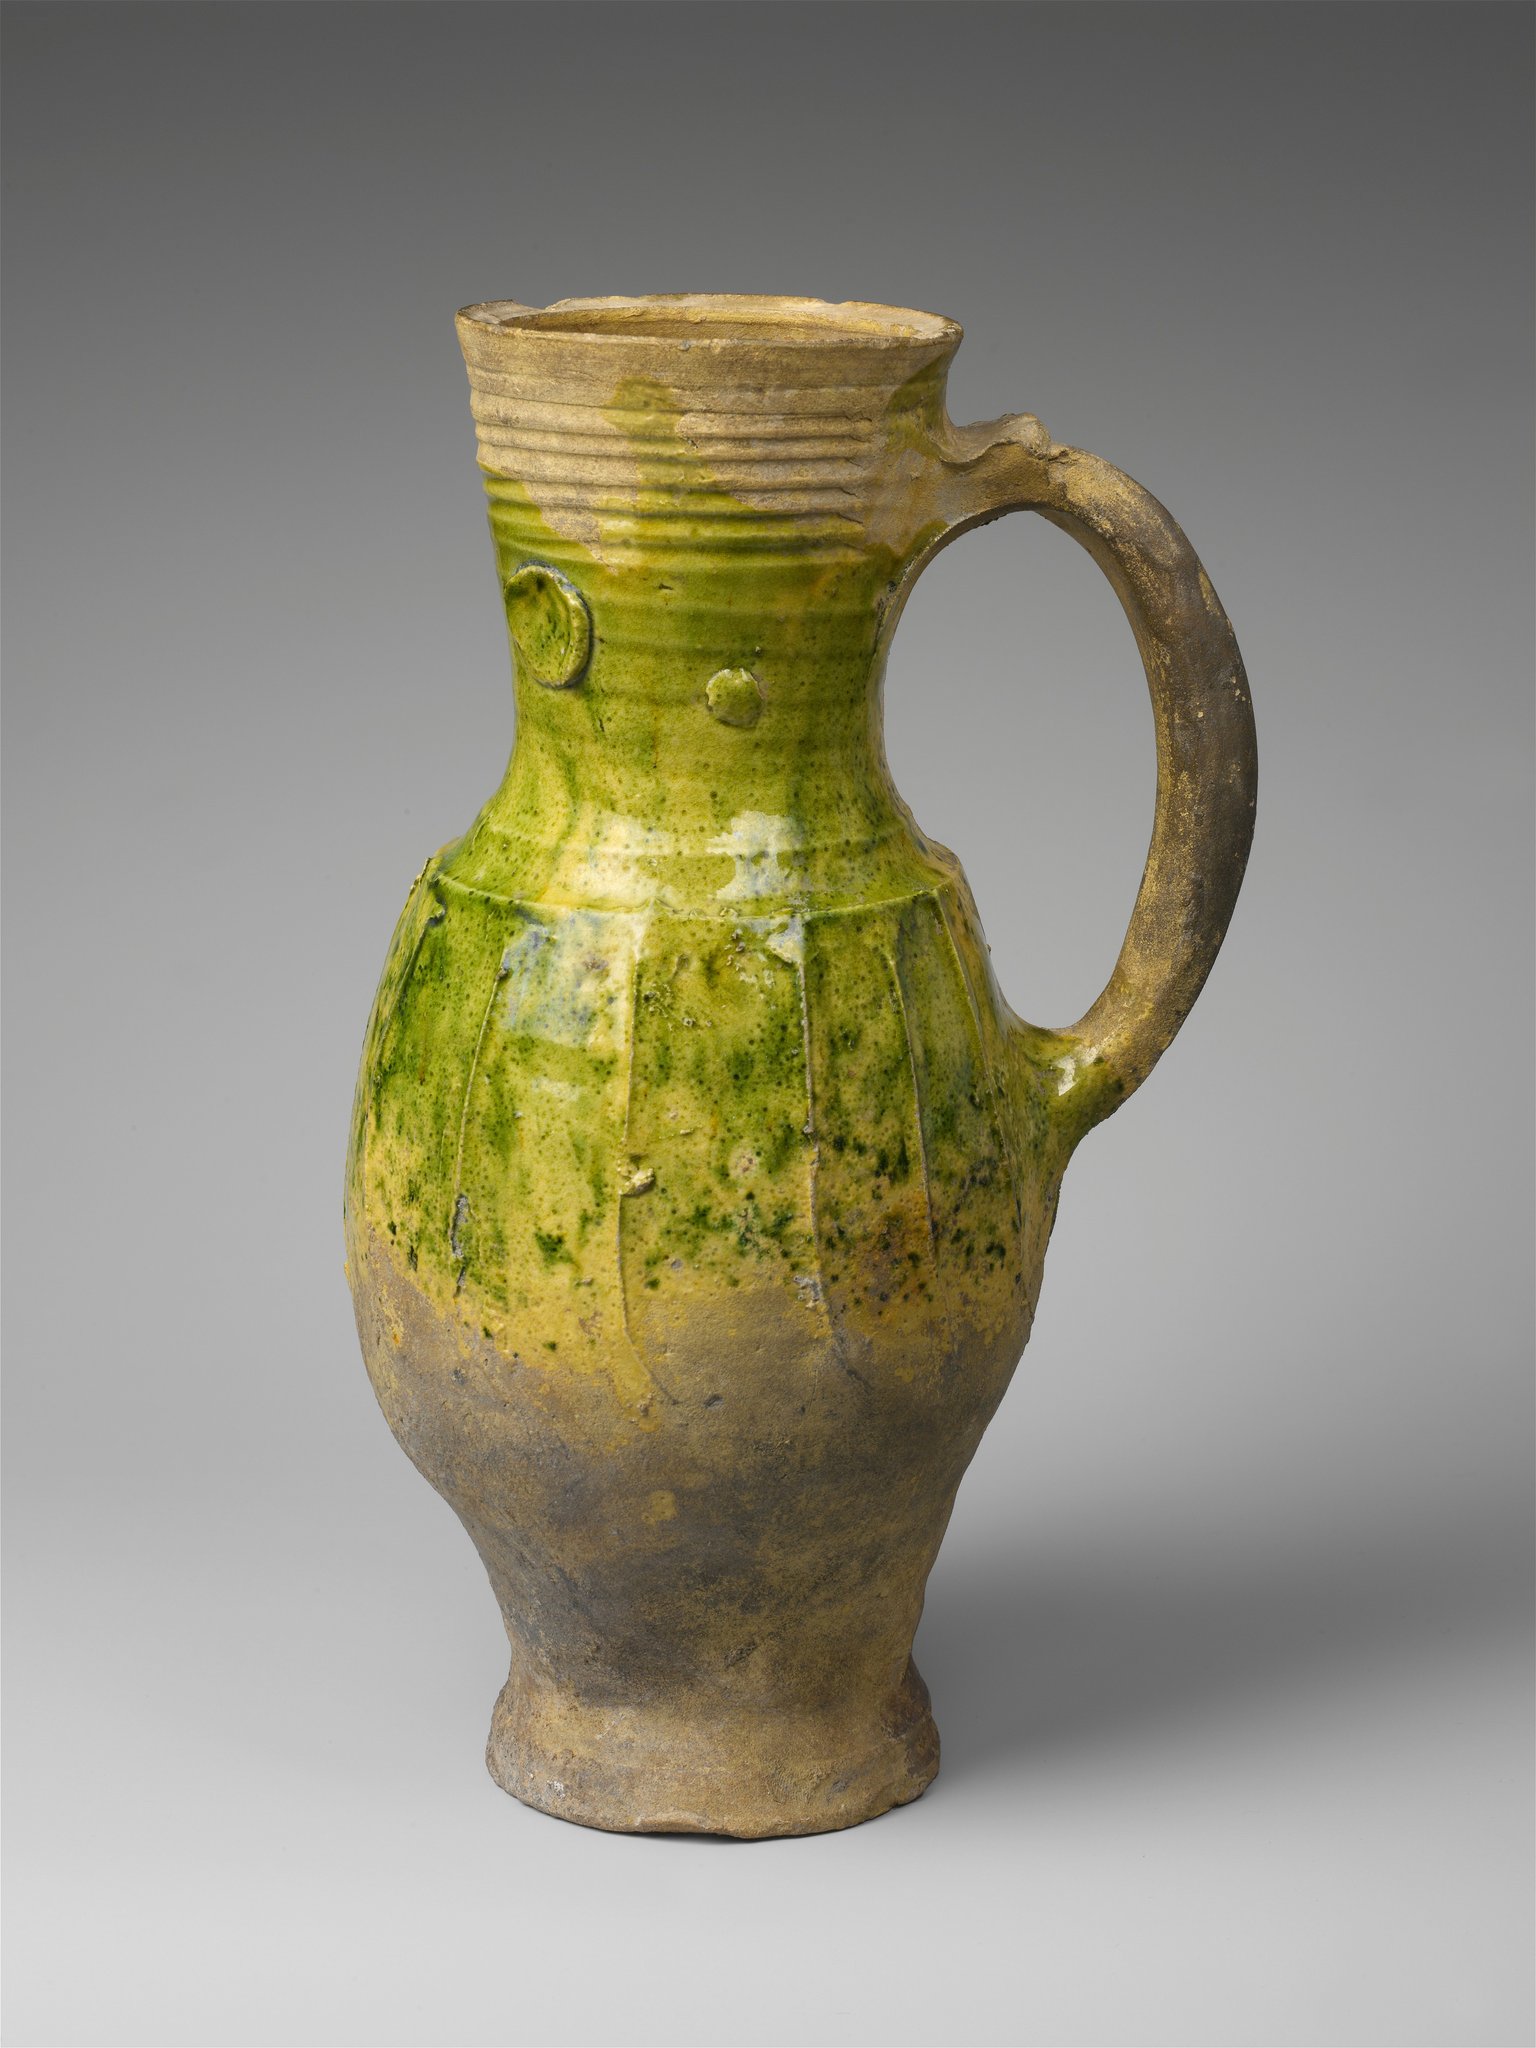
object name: pitcher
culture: french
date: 1201-1300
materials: earthenware, glaze